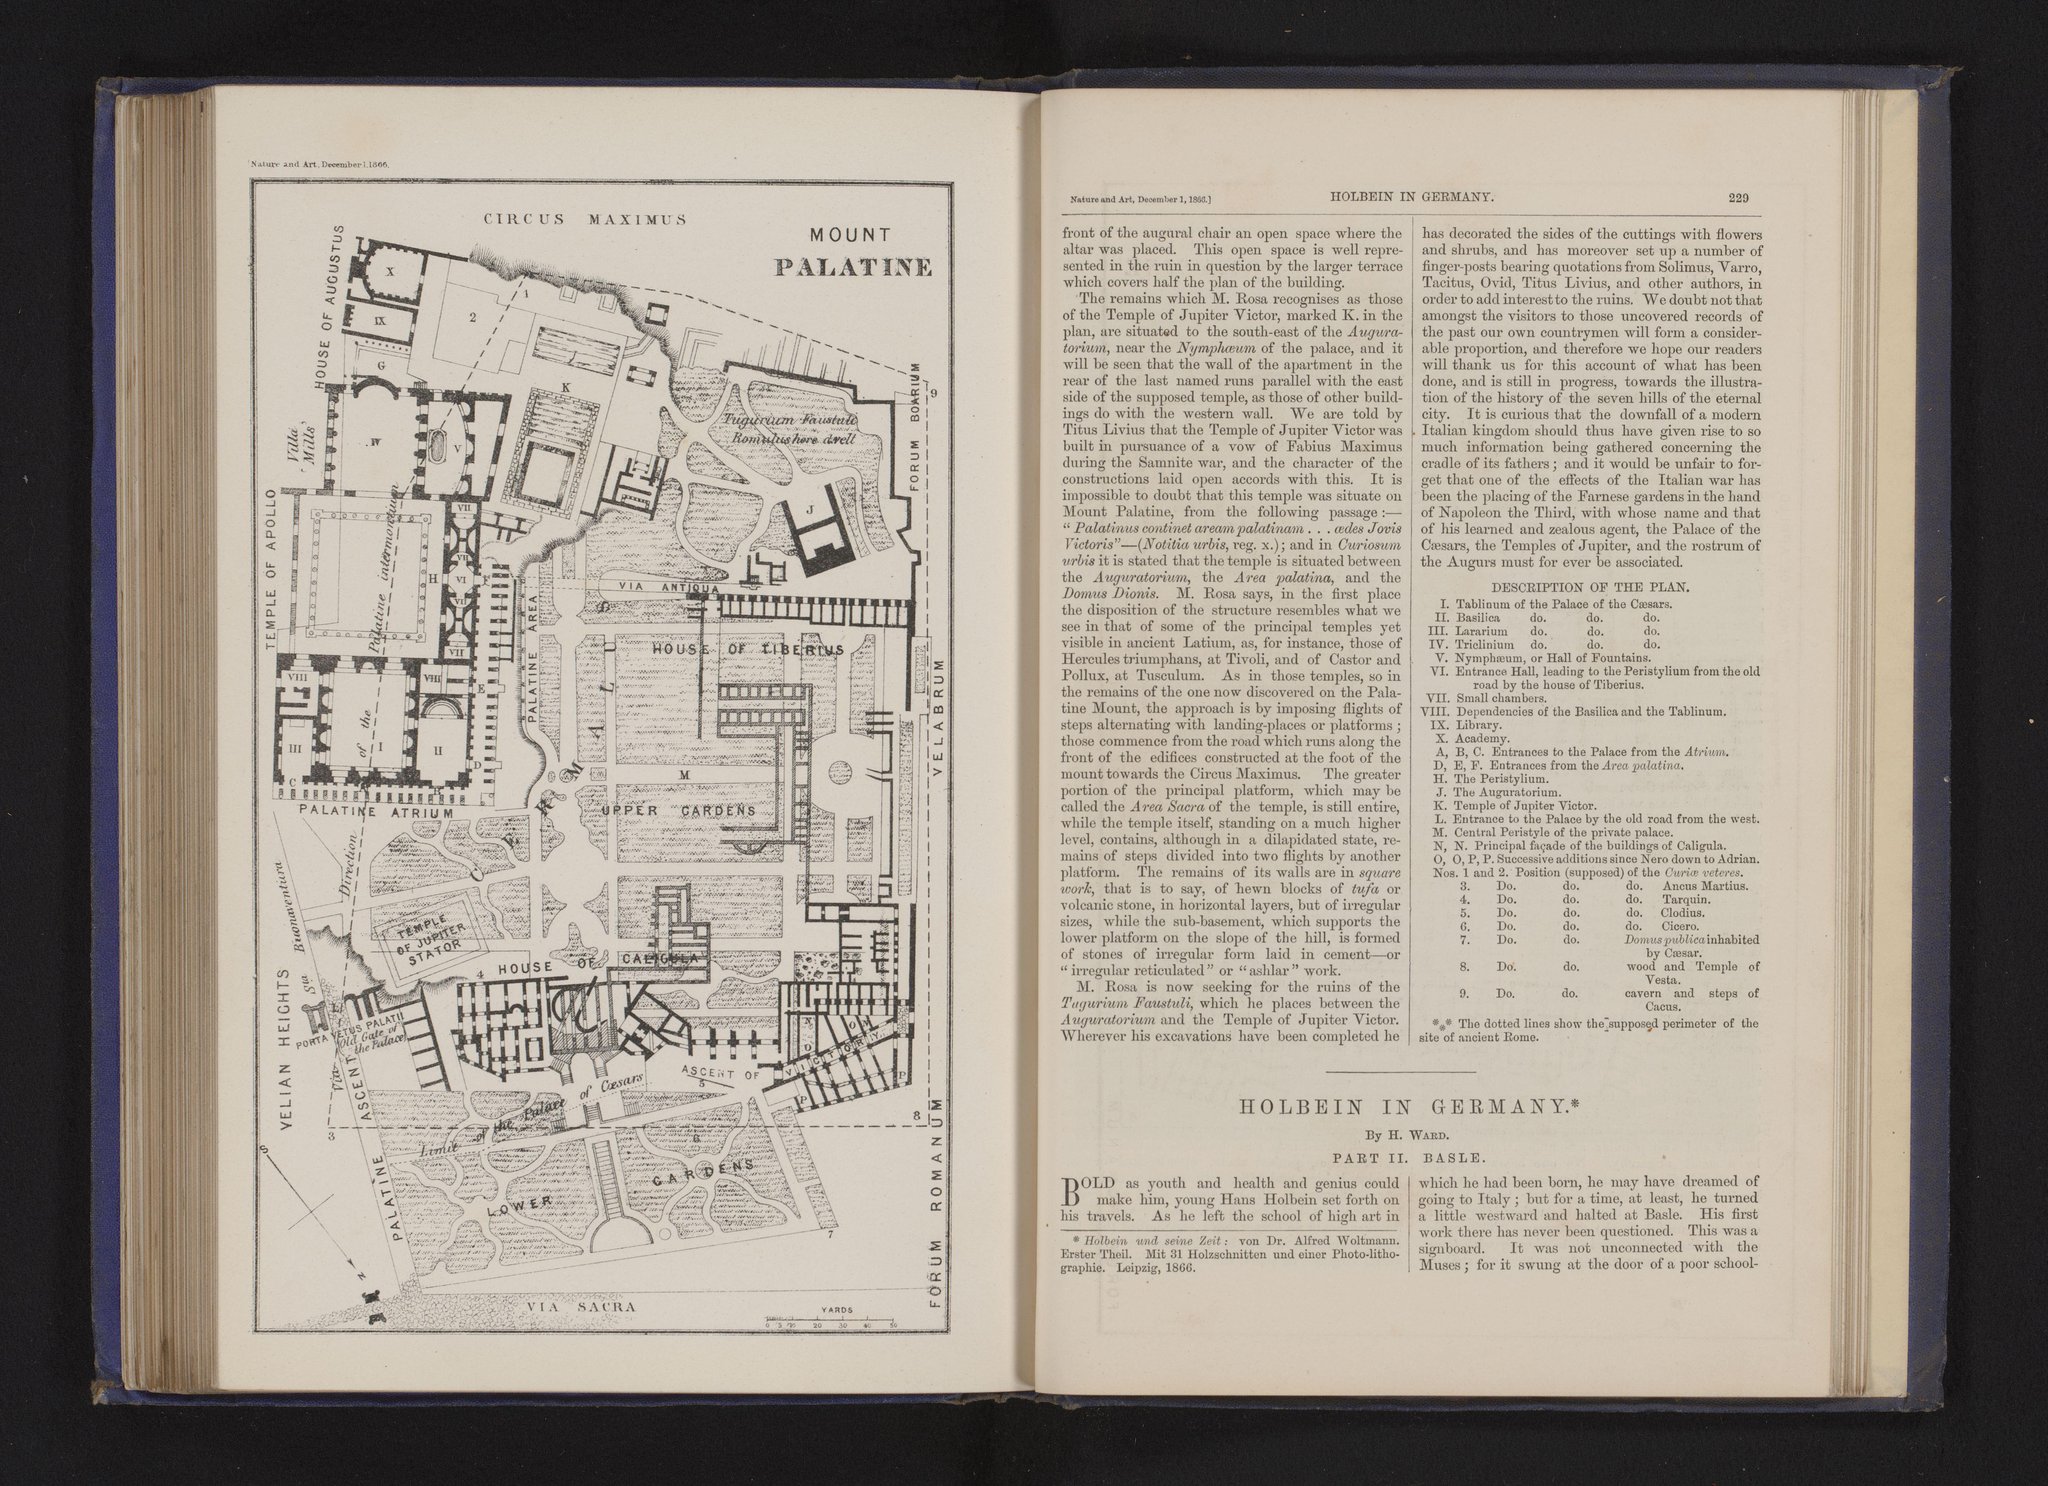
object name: reproduction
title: Reproductie van een plattegrond van het Circus Maximus in Rome, Italië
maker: Anonymous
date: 1861-1866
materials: paper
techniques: photolithography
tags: maps of cities